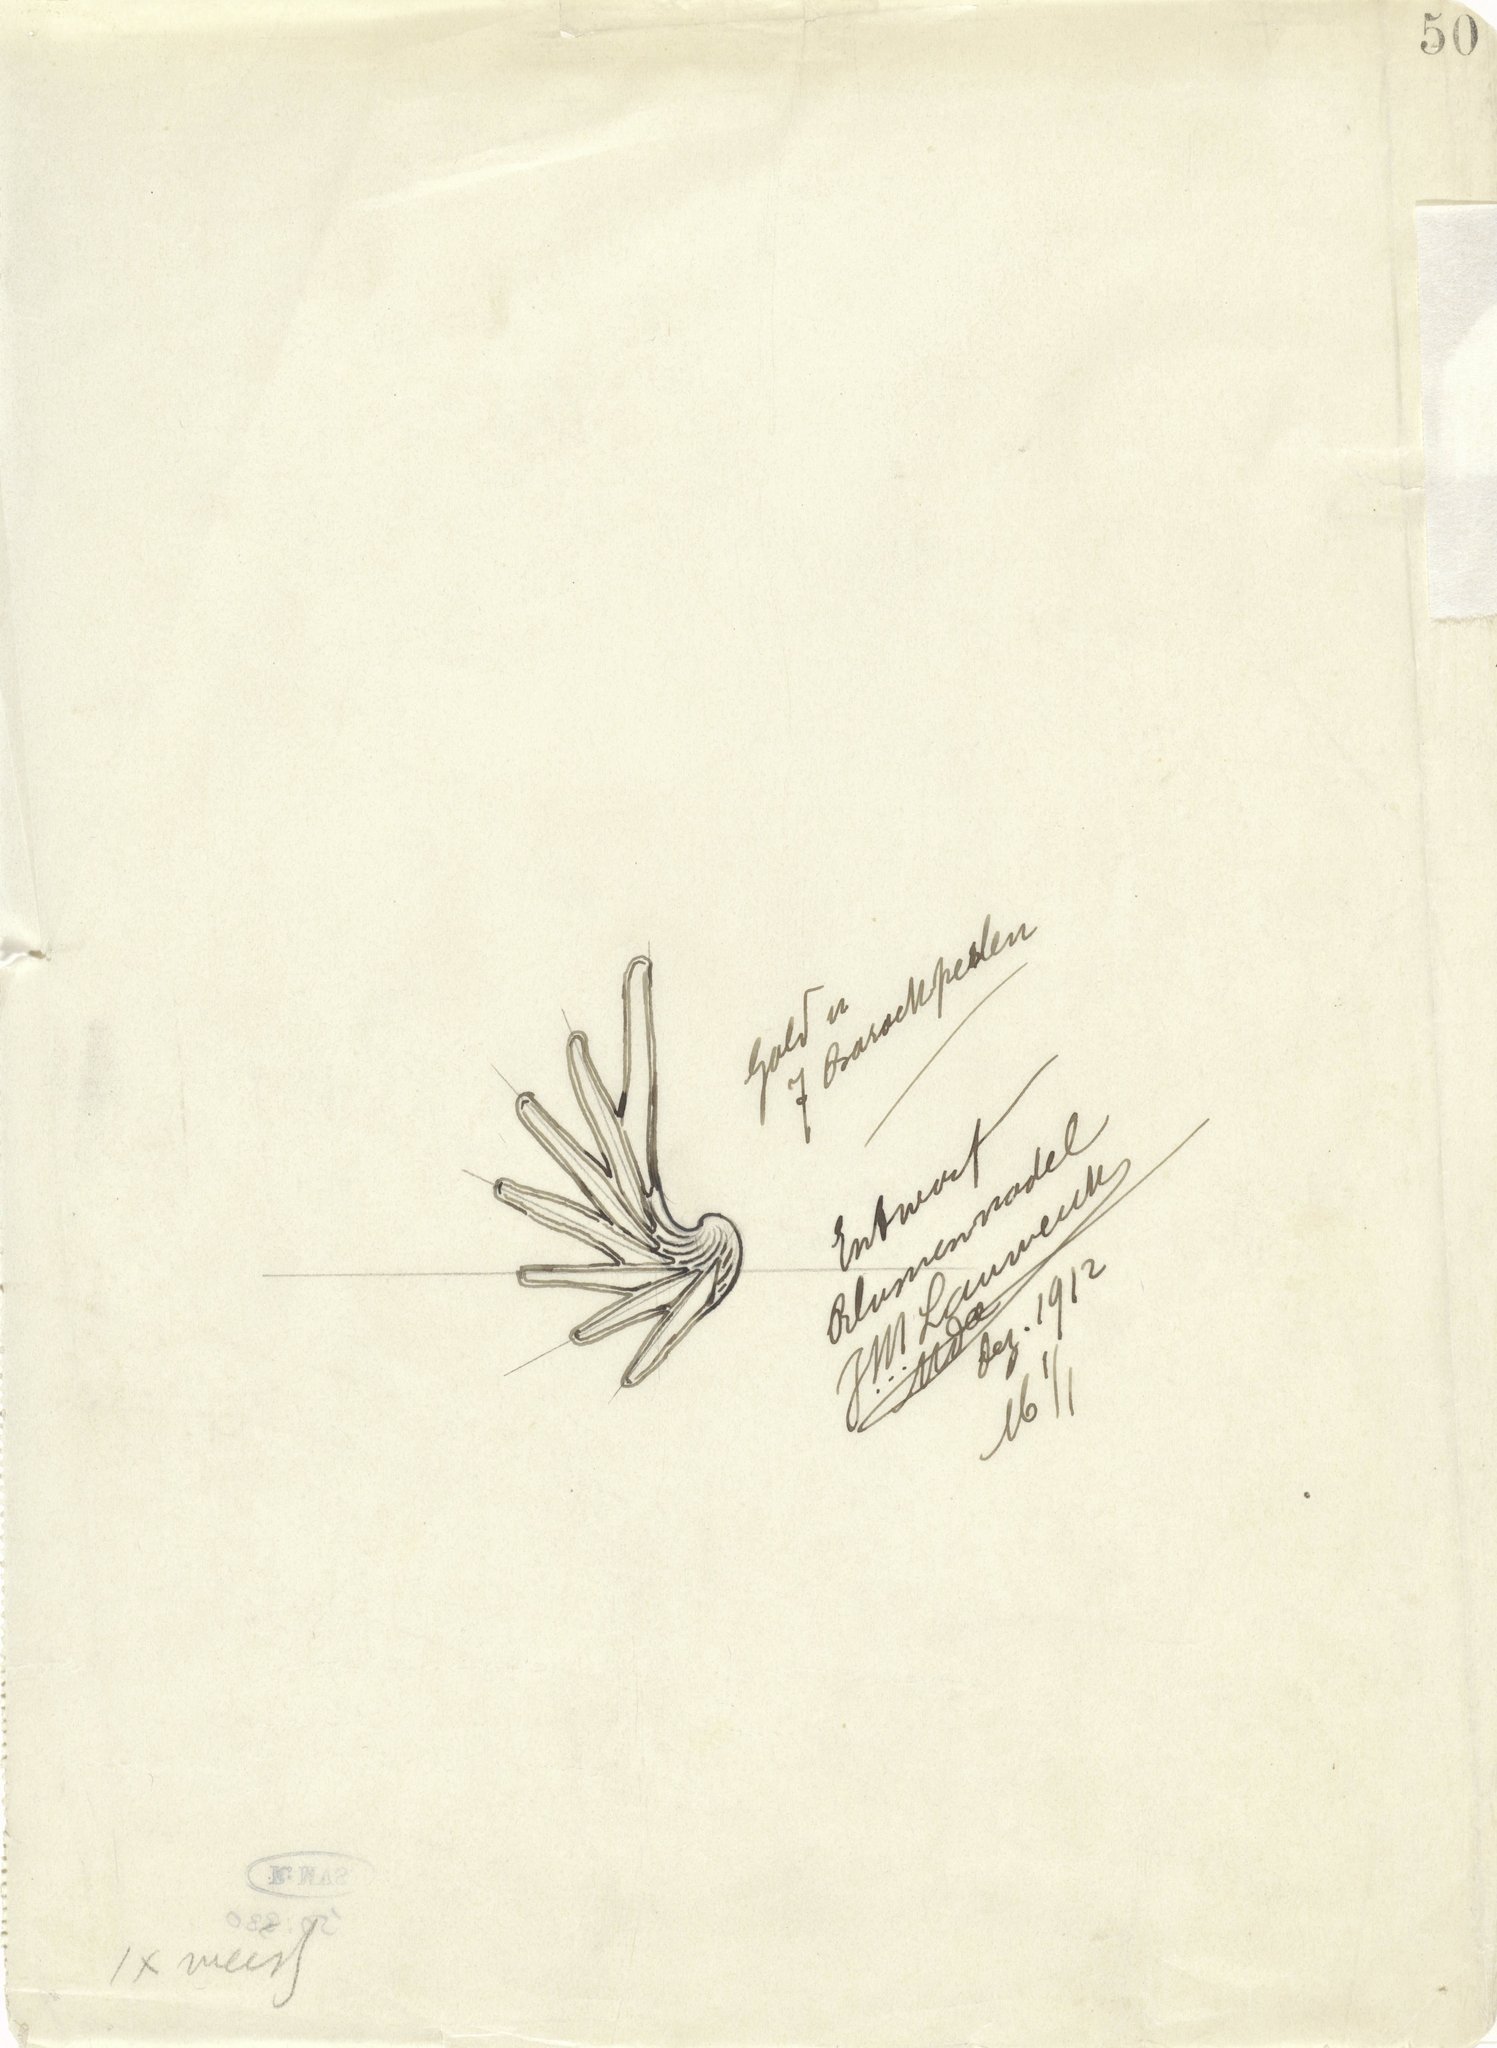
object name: design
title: Ontwerp voor een bloemenspeld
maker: mathieu lauweriks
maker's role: designer, draughtsman, print maker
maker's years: 1864-1932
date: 1912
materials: ink, paper, pencil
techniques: pen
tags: brooch, agraffe, clasp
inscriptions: date: ‘Dez. 1912’